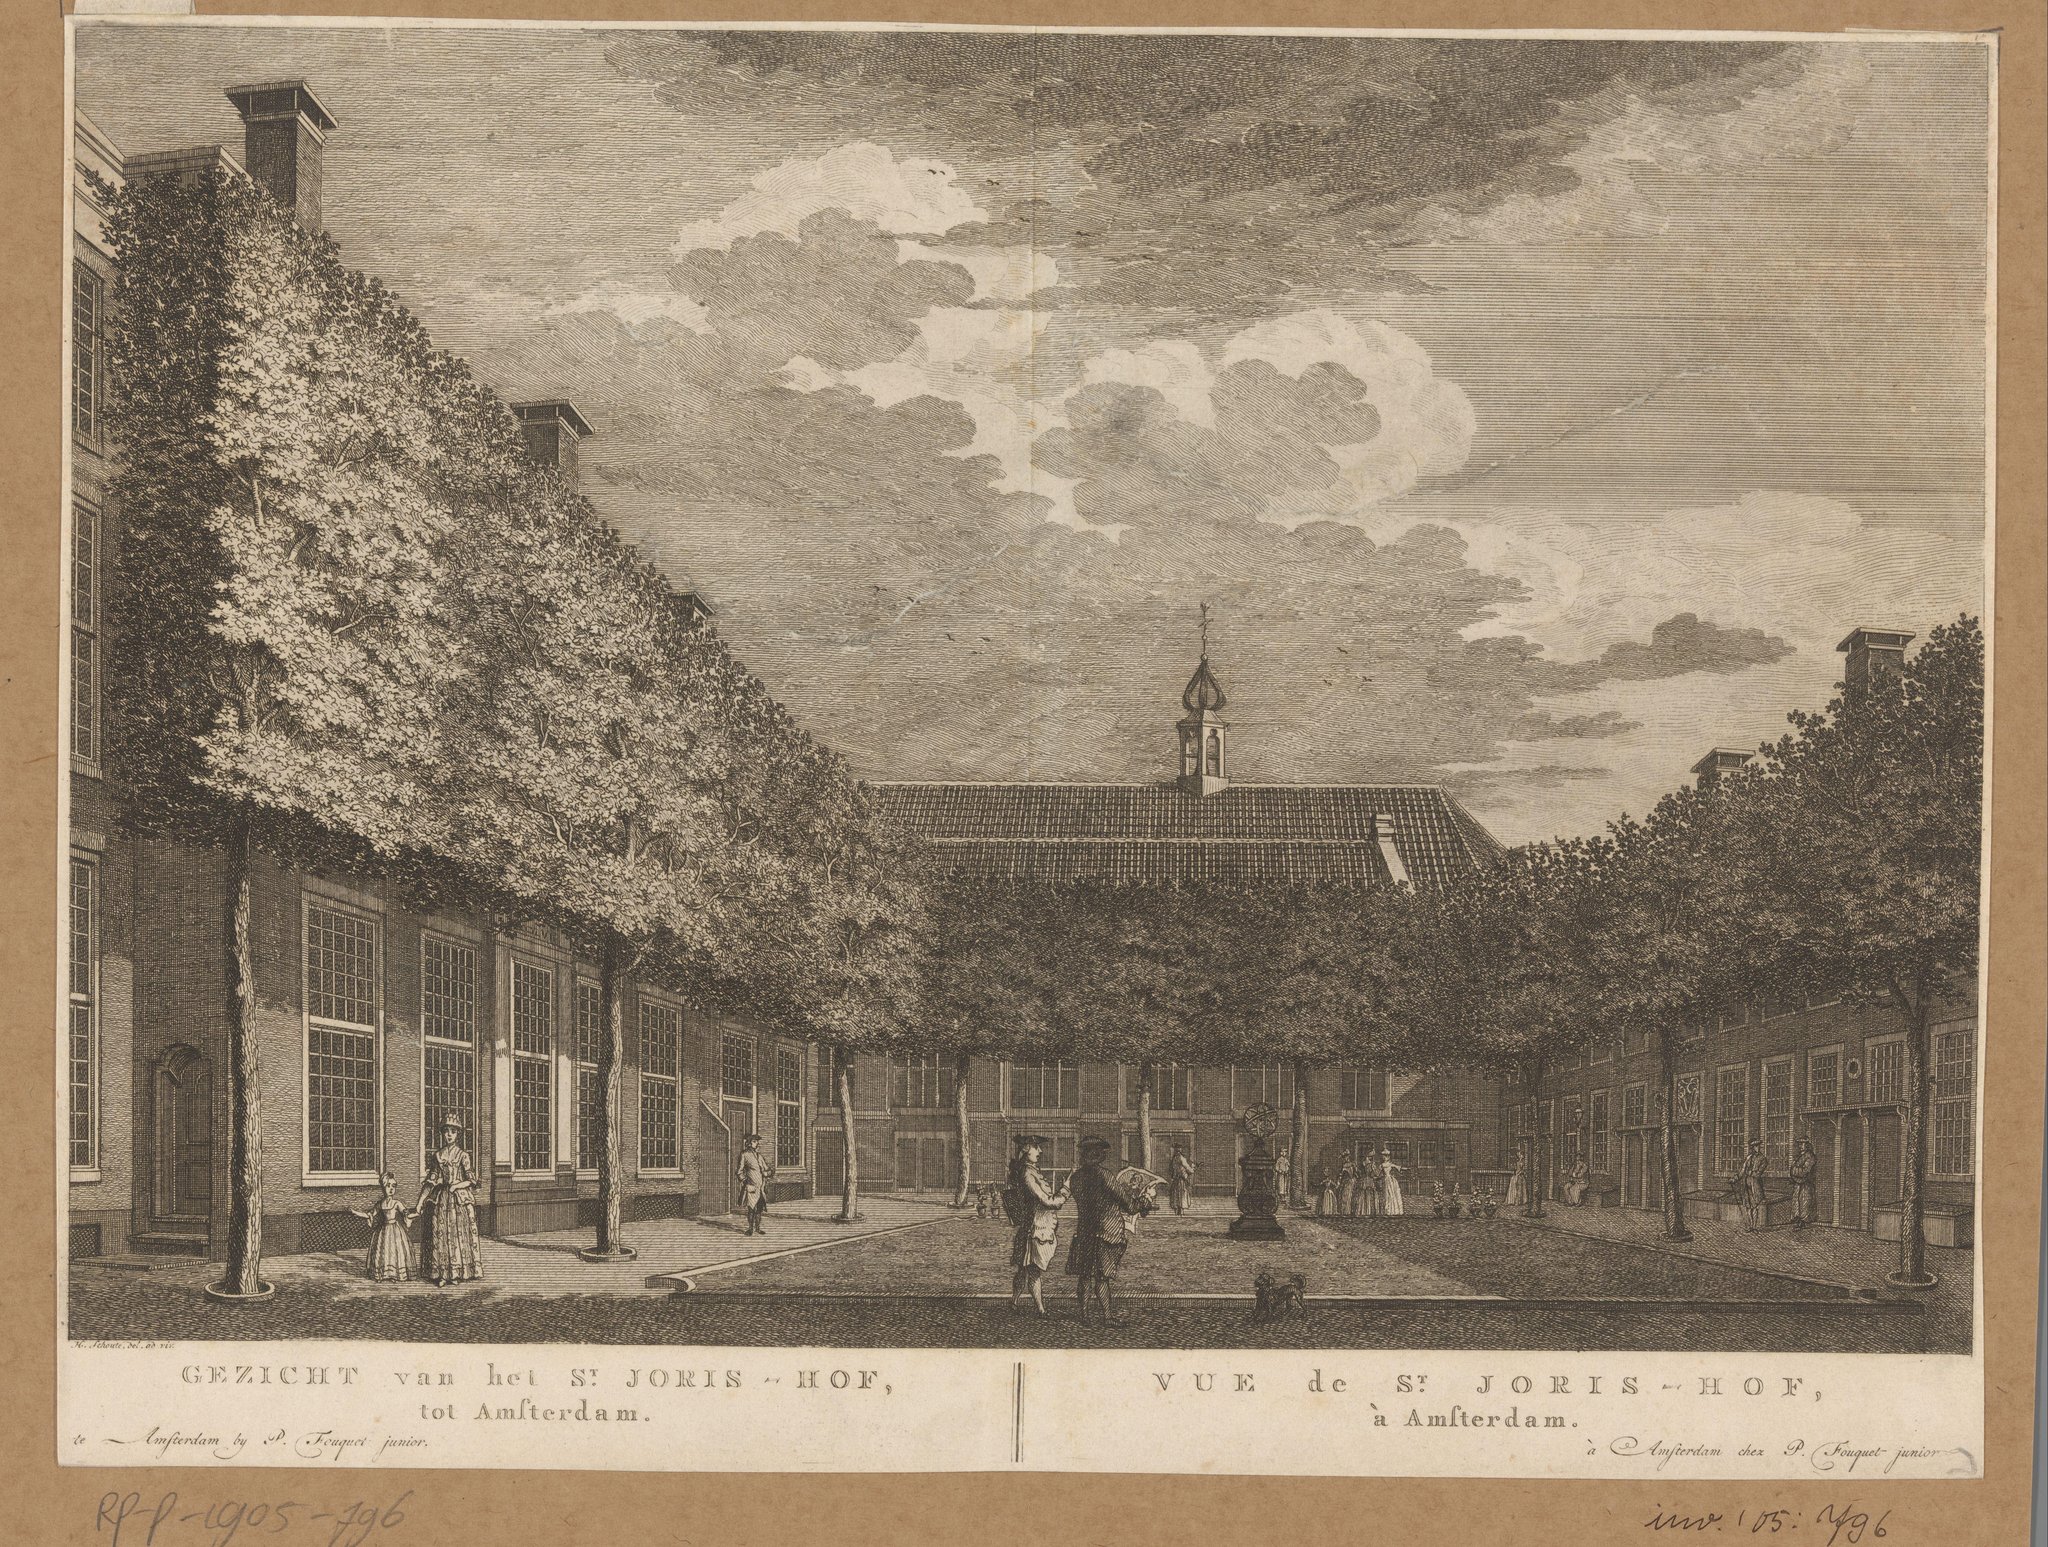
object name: print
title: Gezicht van het St. Joris-Hof, tot Amsterdam / Vue de St. Joris-Hof, à Amsterdam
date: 1770-1783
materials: paper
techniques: etching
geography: amsterdam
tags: alms-house (dutch: 'hofje'), public welfare, church (exterior), courtyard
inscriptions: collector's mark: Lugt 2228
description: Vanaf 1760 gaf Pierre Fouquet stadsgezichten van Amsterdam naar tekeningen van verschillende kunstenaars uit. Deze prenten werden aanvankelijk los verkocht. Later werden ze samengebonden verkocht in verschillende volgordes en aantallen in: (1). Afbeeldingen van de wyd-vermaarde koopstad Amsterdam benevens des zelvs voornaamste gebouwen en gezigten alle naar het leeven getekend / Receuil des edifices les plus considerables et des plus belles vues, de la fameuse ville d'Amsterdam, dessinées d'après nature. Amsterdam: Pierre Fouquet, 1778-1783. (2). Nieuwe atlas, van de voornaamste gebouwen en gezigten der stad Amsterdam, met derzelver beknopte beschryvingen. 2 dln. Amsterdam: Daniël Jean Changuion en Petrus den Hengst [in opdracht van Pierre Fouquet], 1783. Ook werden er door verschillende uitgevers tussen 1788 (Amsterdam: Petrus Conradi) en 1805 (Amsterdam: Evert Maaskamp) heruitgaven gepubliceerd.